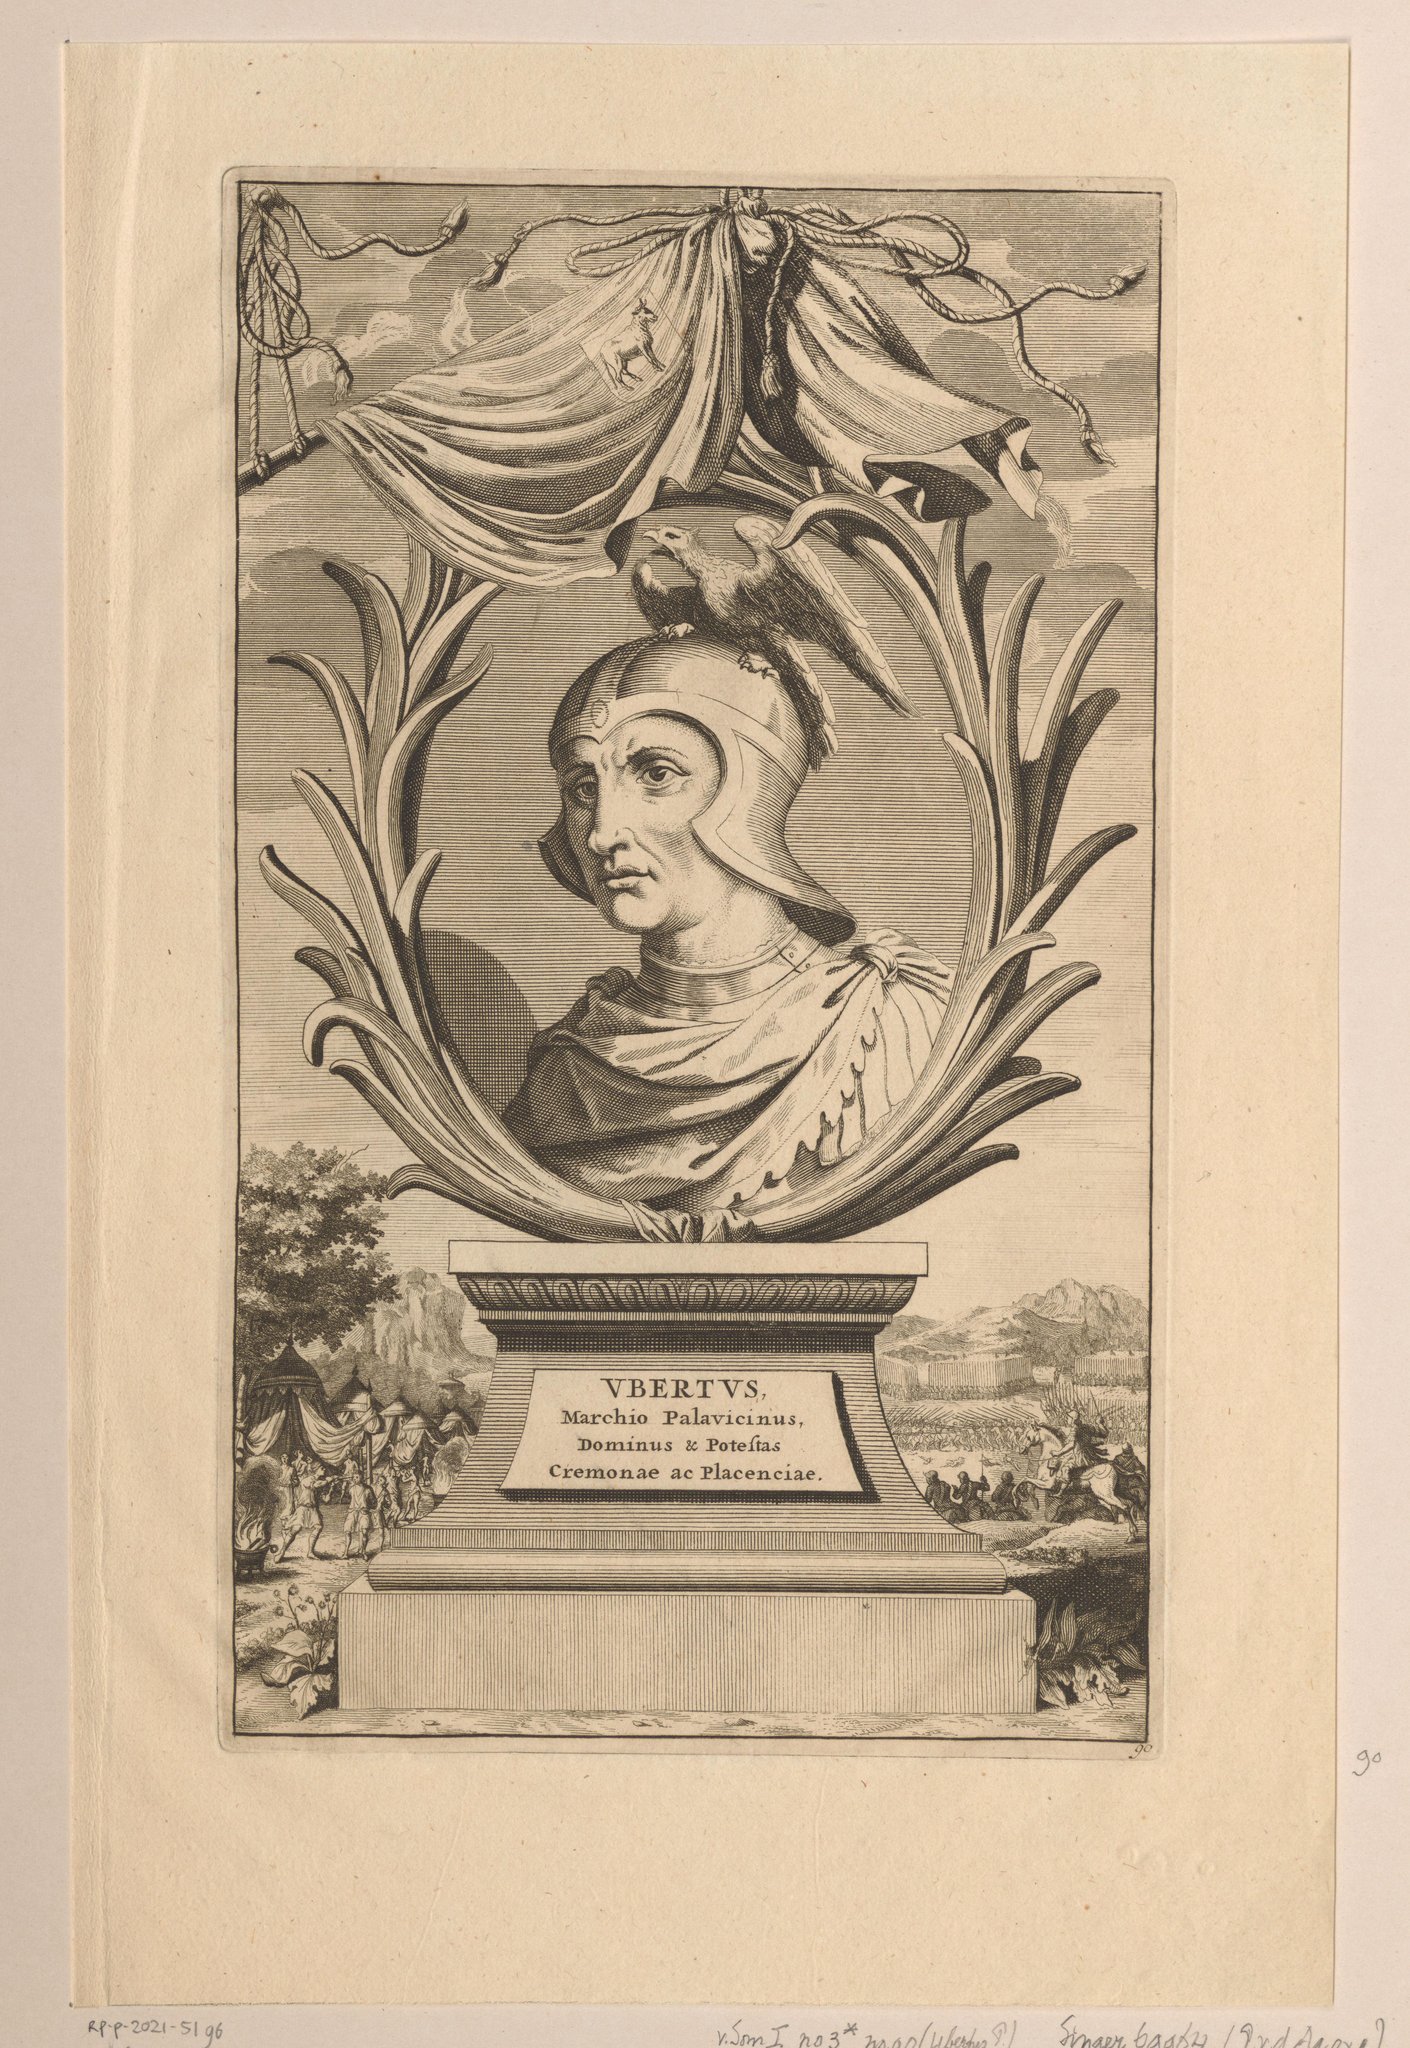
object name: print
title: Principum et illustrium quorundam virorum qui in Europa alibique terrarum quam fama quam eruditione celebres fuerunt, verae imagines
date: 1710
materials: paper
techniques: engraving, etching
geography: leiden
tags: helmet, (military) camp with tents, adult man, historical persons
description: Prent uit de serie: Principum et illustrium quorundam virorum qui in Europa alibique terrarum quam fama quam eruditione celebres fuerunt, verae imagines. Leiden: Pieter van der Aa, [1710].